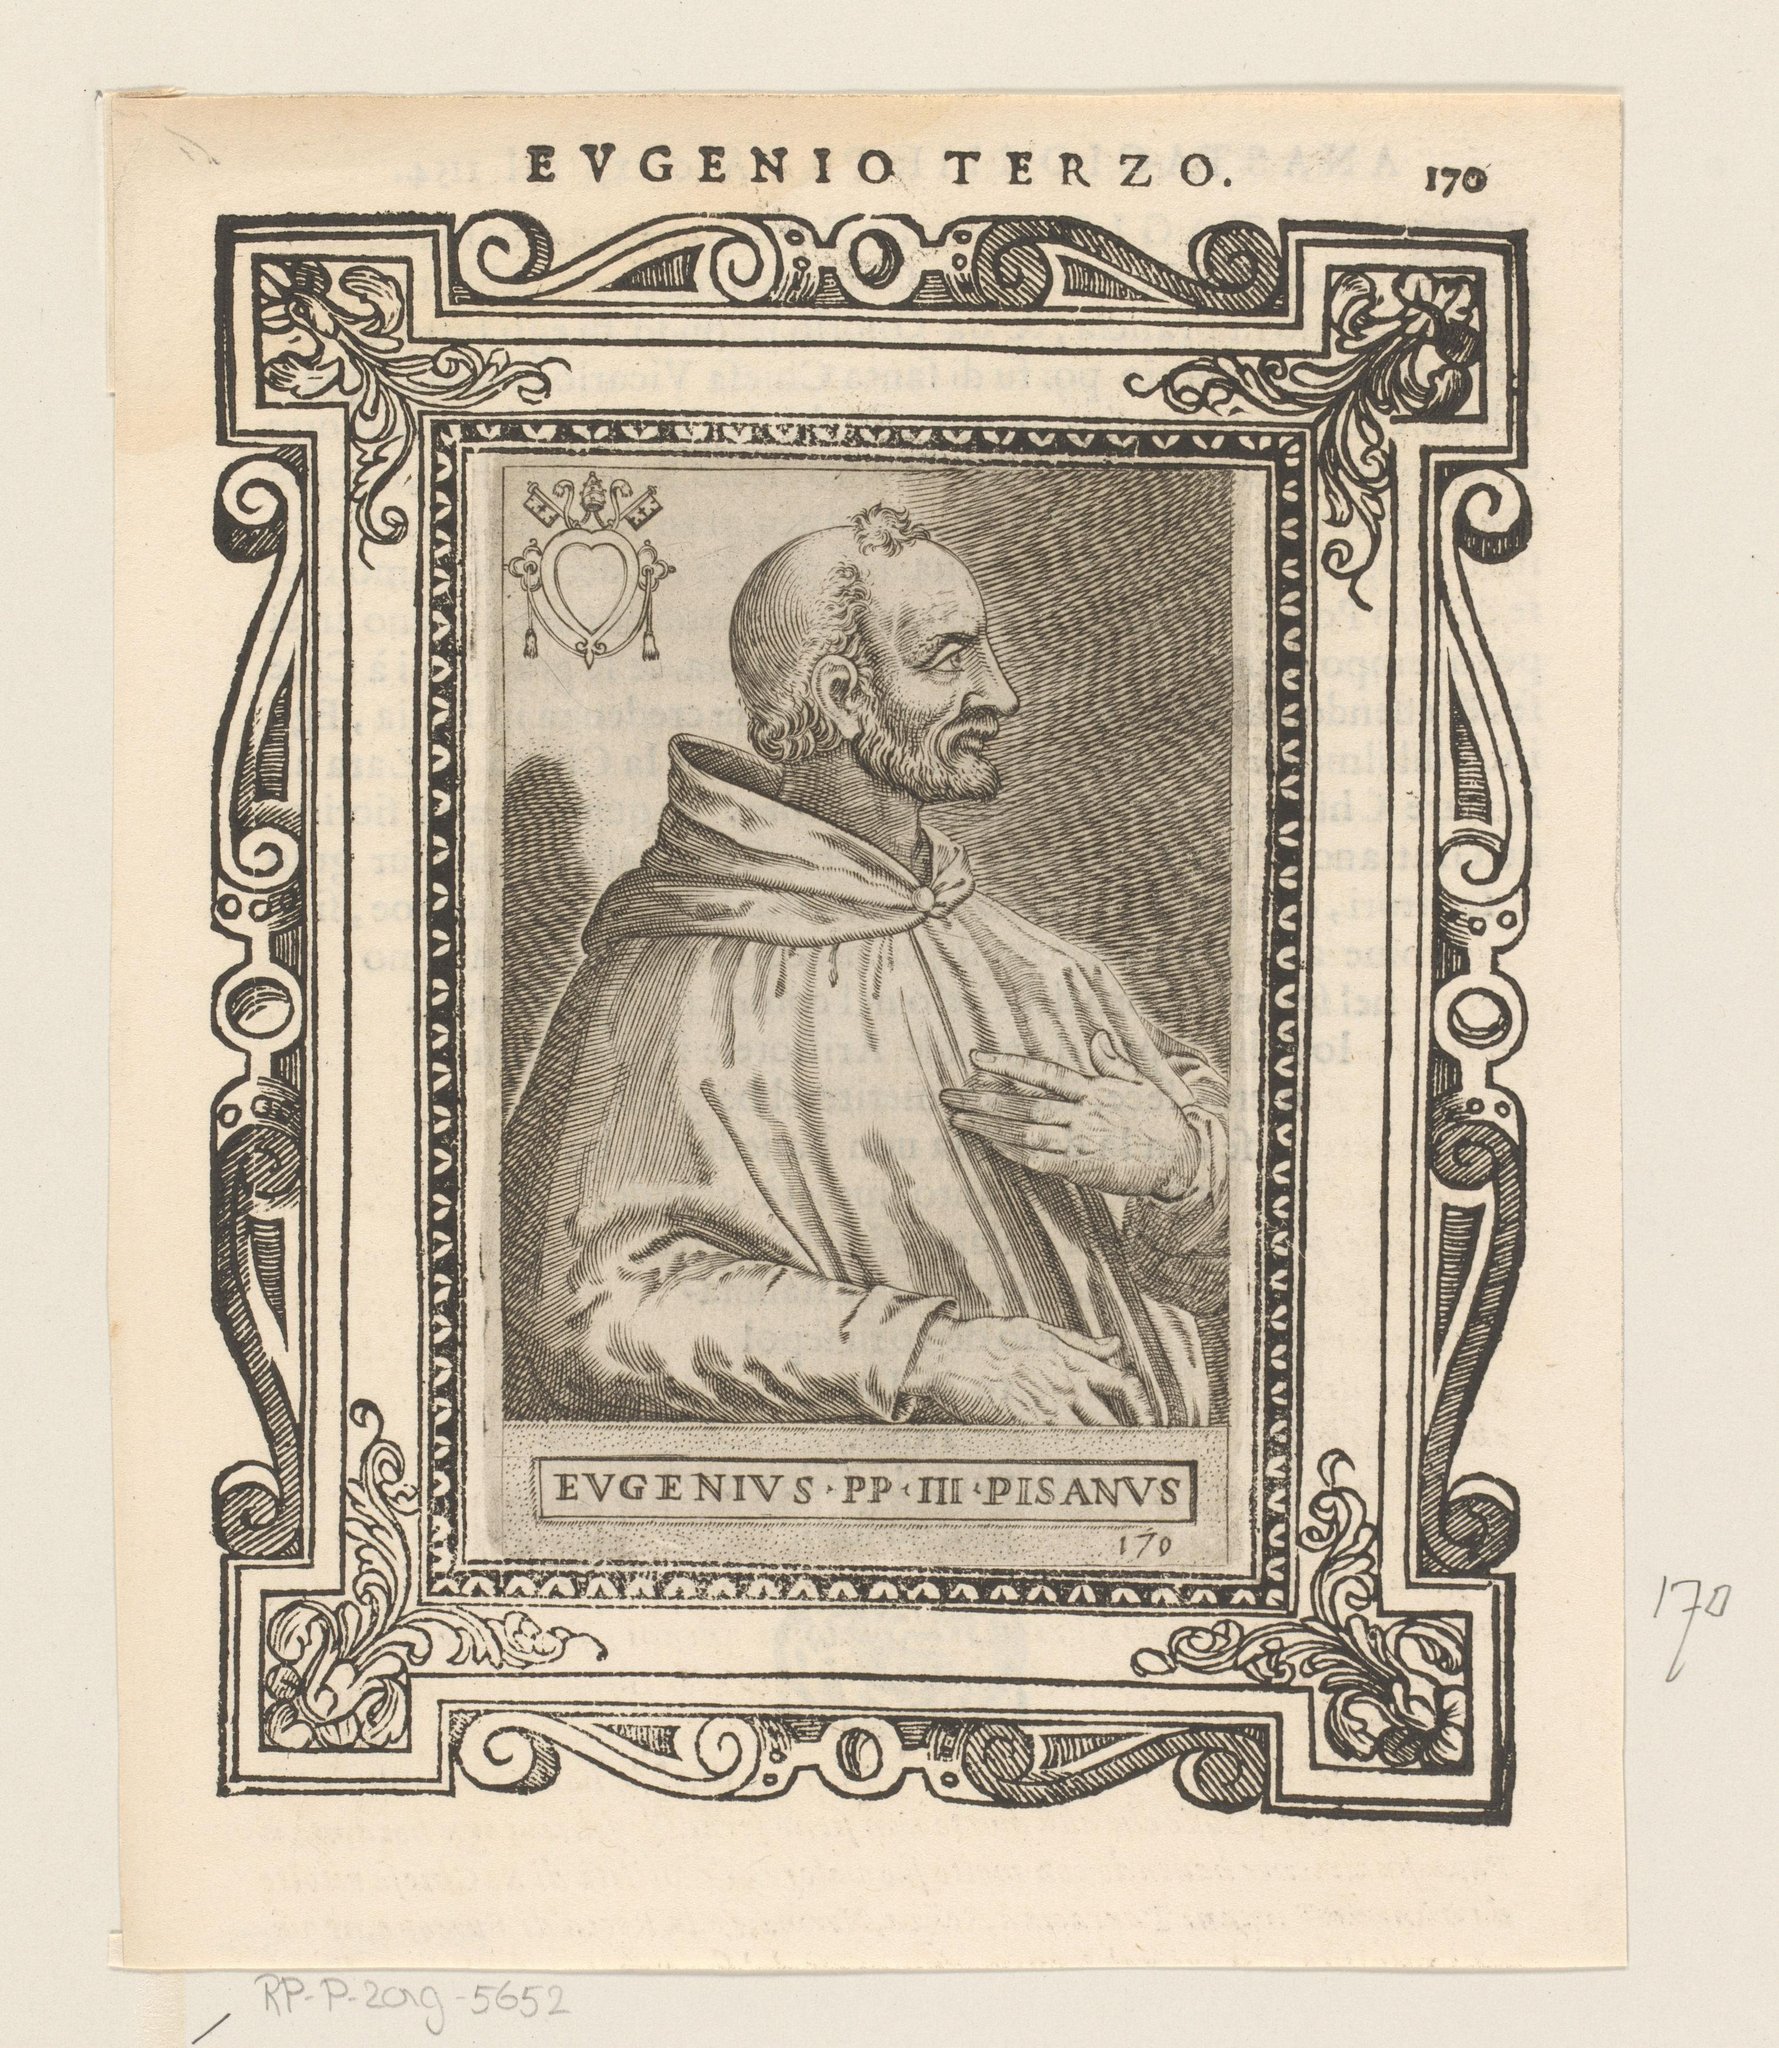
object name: book illustration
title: Portret van paus Eugenius III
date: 1587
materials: paper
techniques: engraving, letterpress printing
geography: rome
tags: historical persons, pope, armorial bearing, heraldry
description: Prent uit: Ciccarelli, Antonio. Le vite de Pontefici di Antonio Ciccarelli (...). Rome: Domenico Basa, 1587. Prent voor het eerst verschenen in: Cavalieri, Giovanni Battista de'. Pontificum romanorum effigies (...). Rome: Domenico Basa en Francesco Zanetti, 1580. Prent ook gebruikt in latere publicaties.